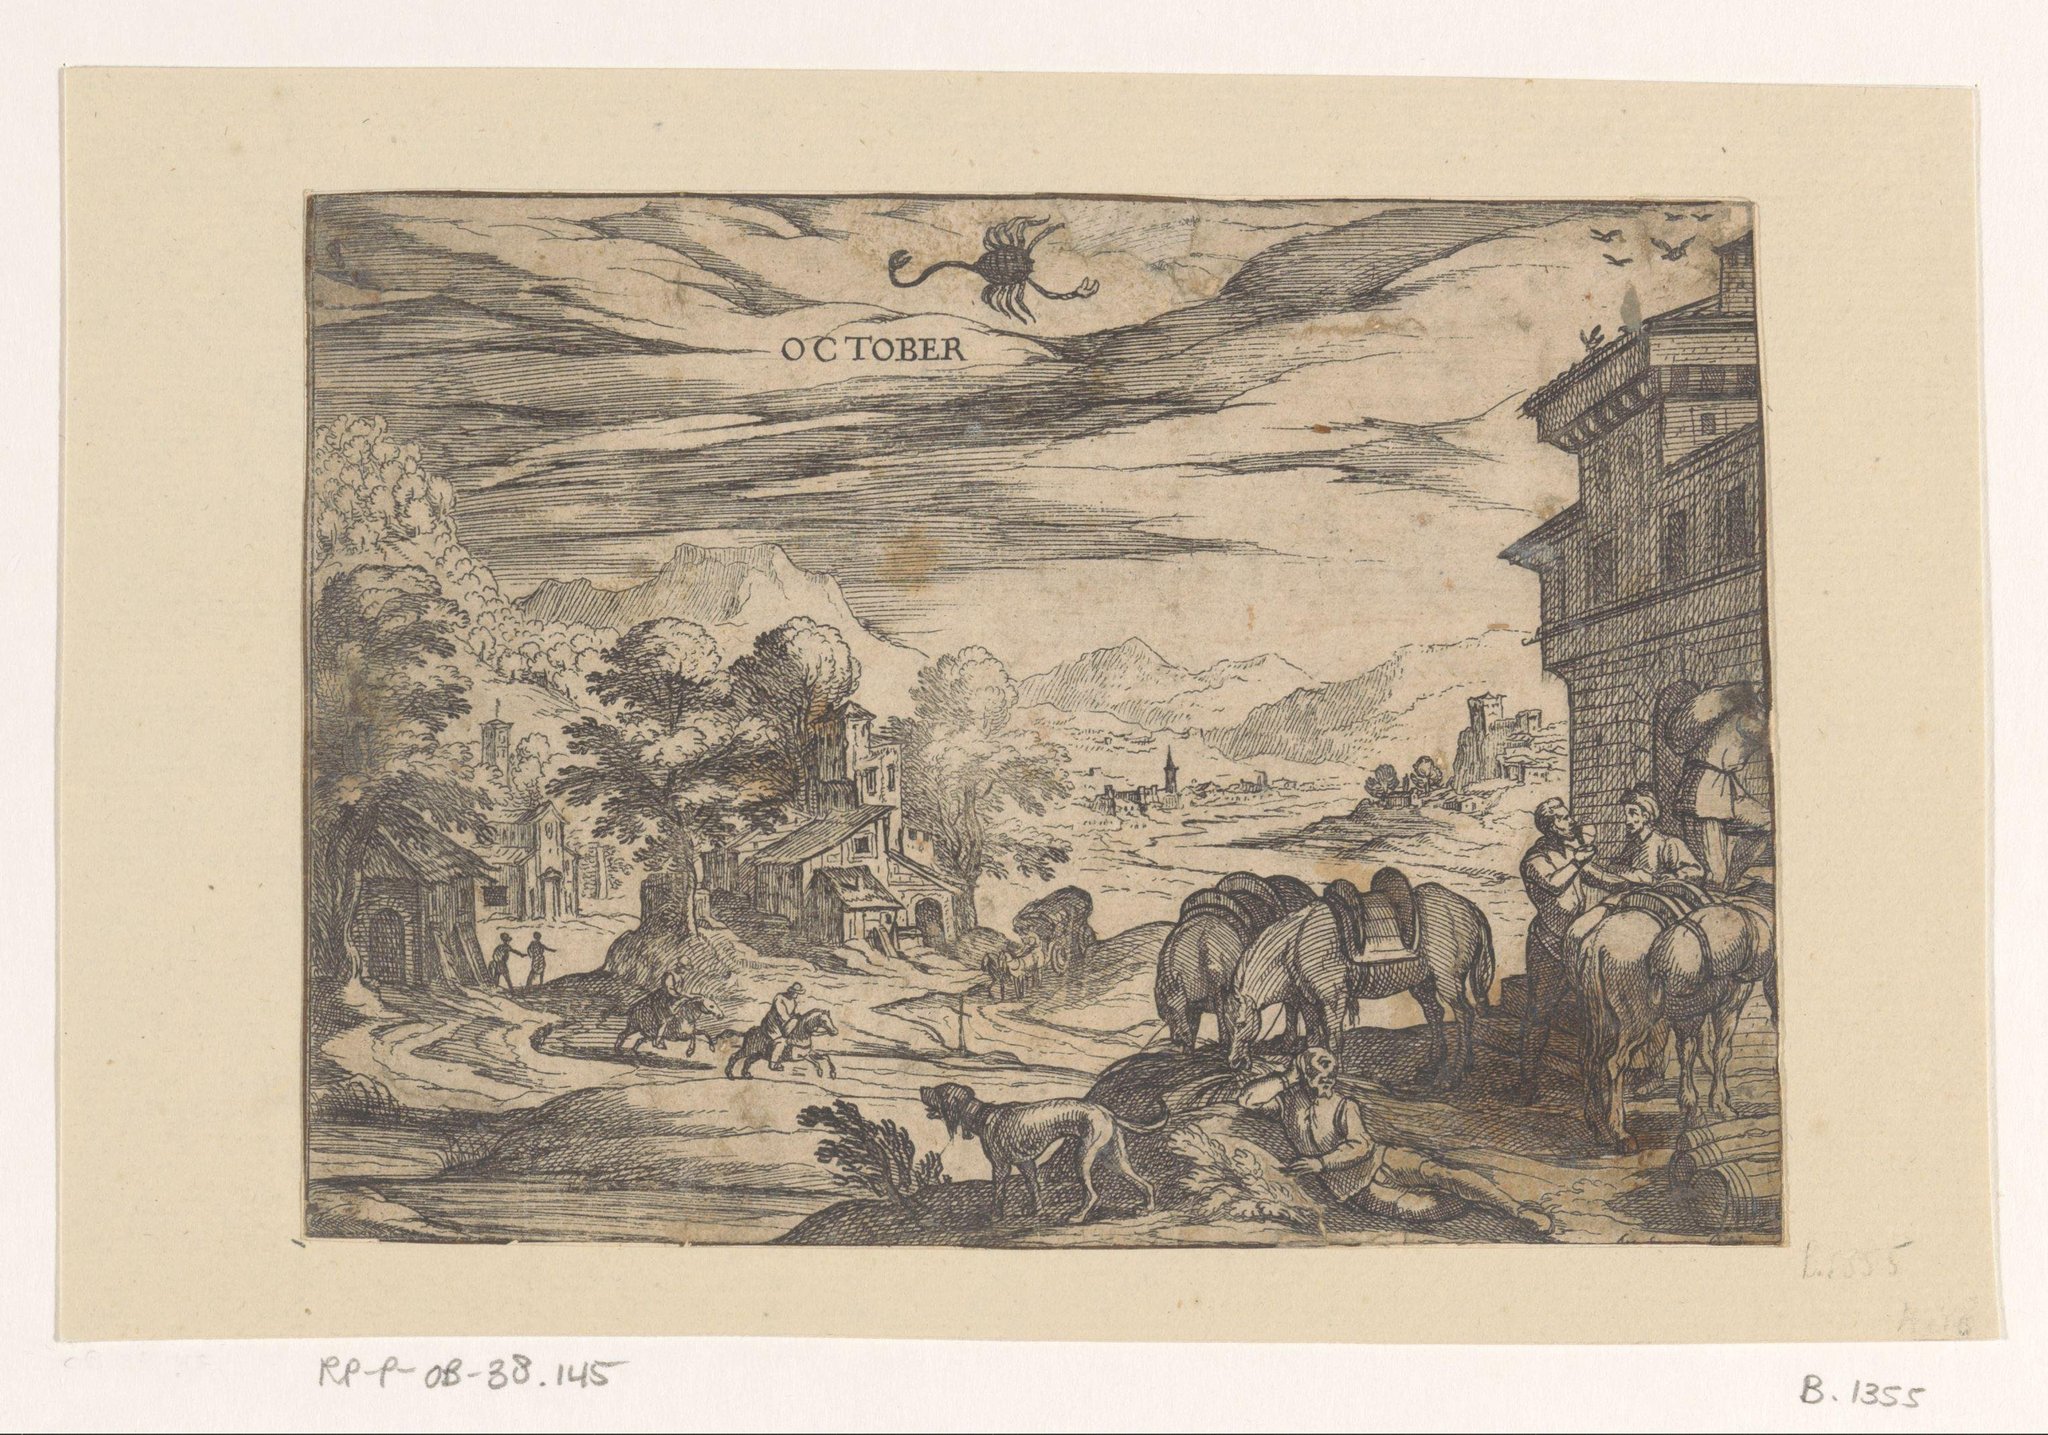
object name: print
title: Oktober: wijn proeven (schorpioen)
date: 1575-1613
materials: paper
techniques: etching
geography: italy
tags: landscape symbolizing october, scorpio (zodiacal sign of october), wine ~ alcoholic drinks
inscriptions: collector's mark: Lugt 240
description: Landschap dat de maand oktober verbeeldt. Landschap met mensen die wijn drinken. Midden boven het symbool voor het sterrenbeeld schorpioen.